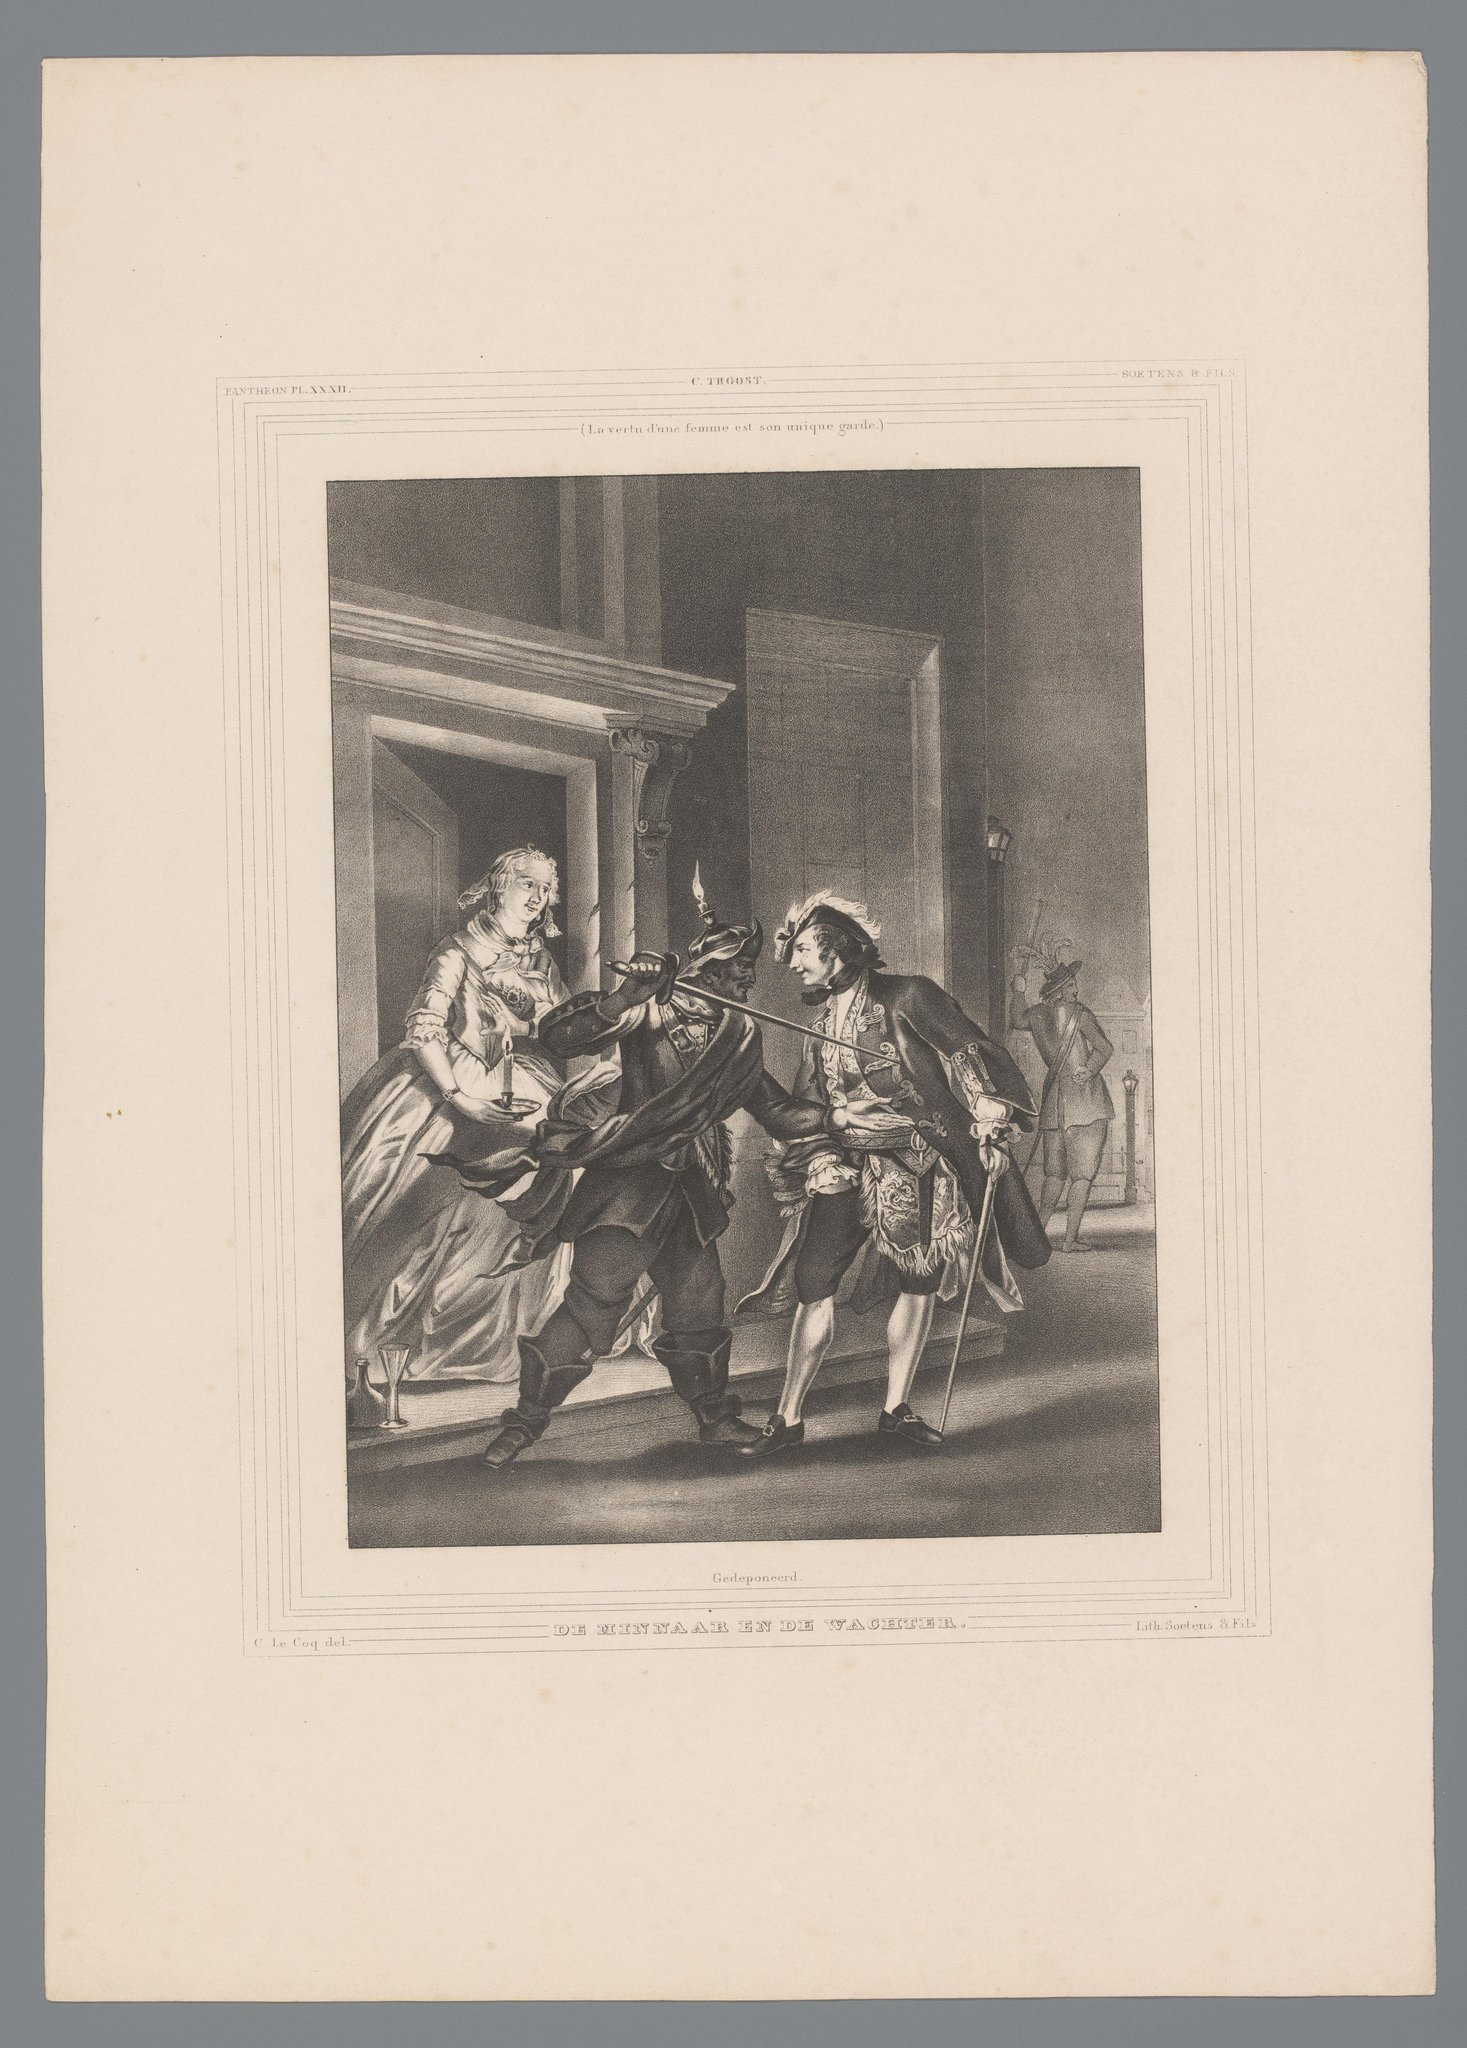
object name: print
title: Pantheon van Nederlandse kunstschilders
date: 1837-1840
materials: paper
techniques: lithograph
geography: the hague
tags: house-guard, doorkeeper, janitor, candle, lovers; courting, flirting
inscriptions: collector's mark: Lugt 2228, : ‘Gedeponeerd’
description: Bericht in ''s Gravenhaagsche stads-almanak' over 'Het Pantheon of de tempel der onsterfelijkheid voor Neêrlands kunstschilders' uitgegeven bij Soetens & Fils met één plaat per maand. Ook een bericht in 'Album voor maatschappelijke opvoeding' over de eerste plaat van de serie 'Pantheon voor Neérlands Kunstschilders' die verschijnt in 1837.